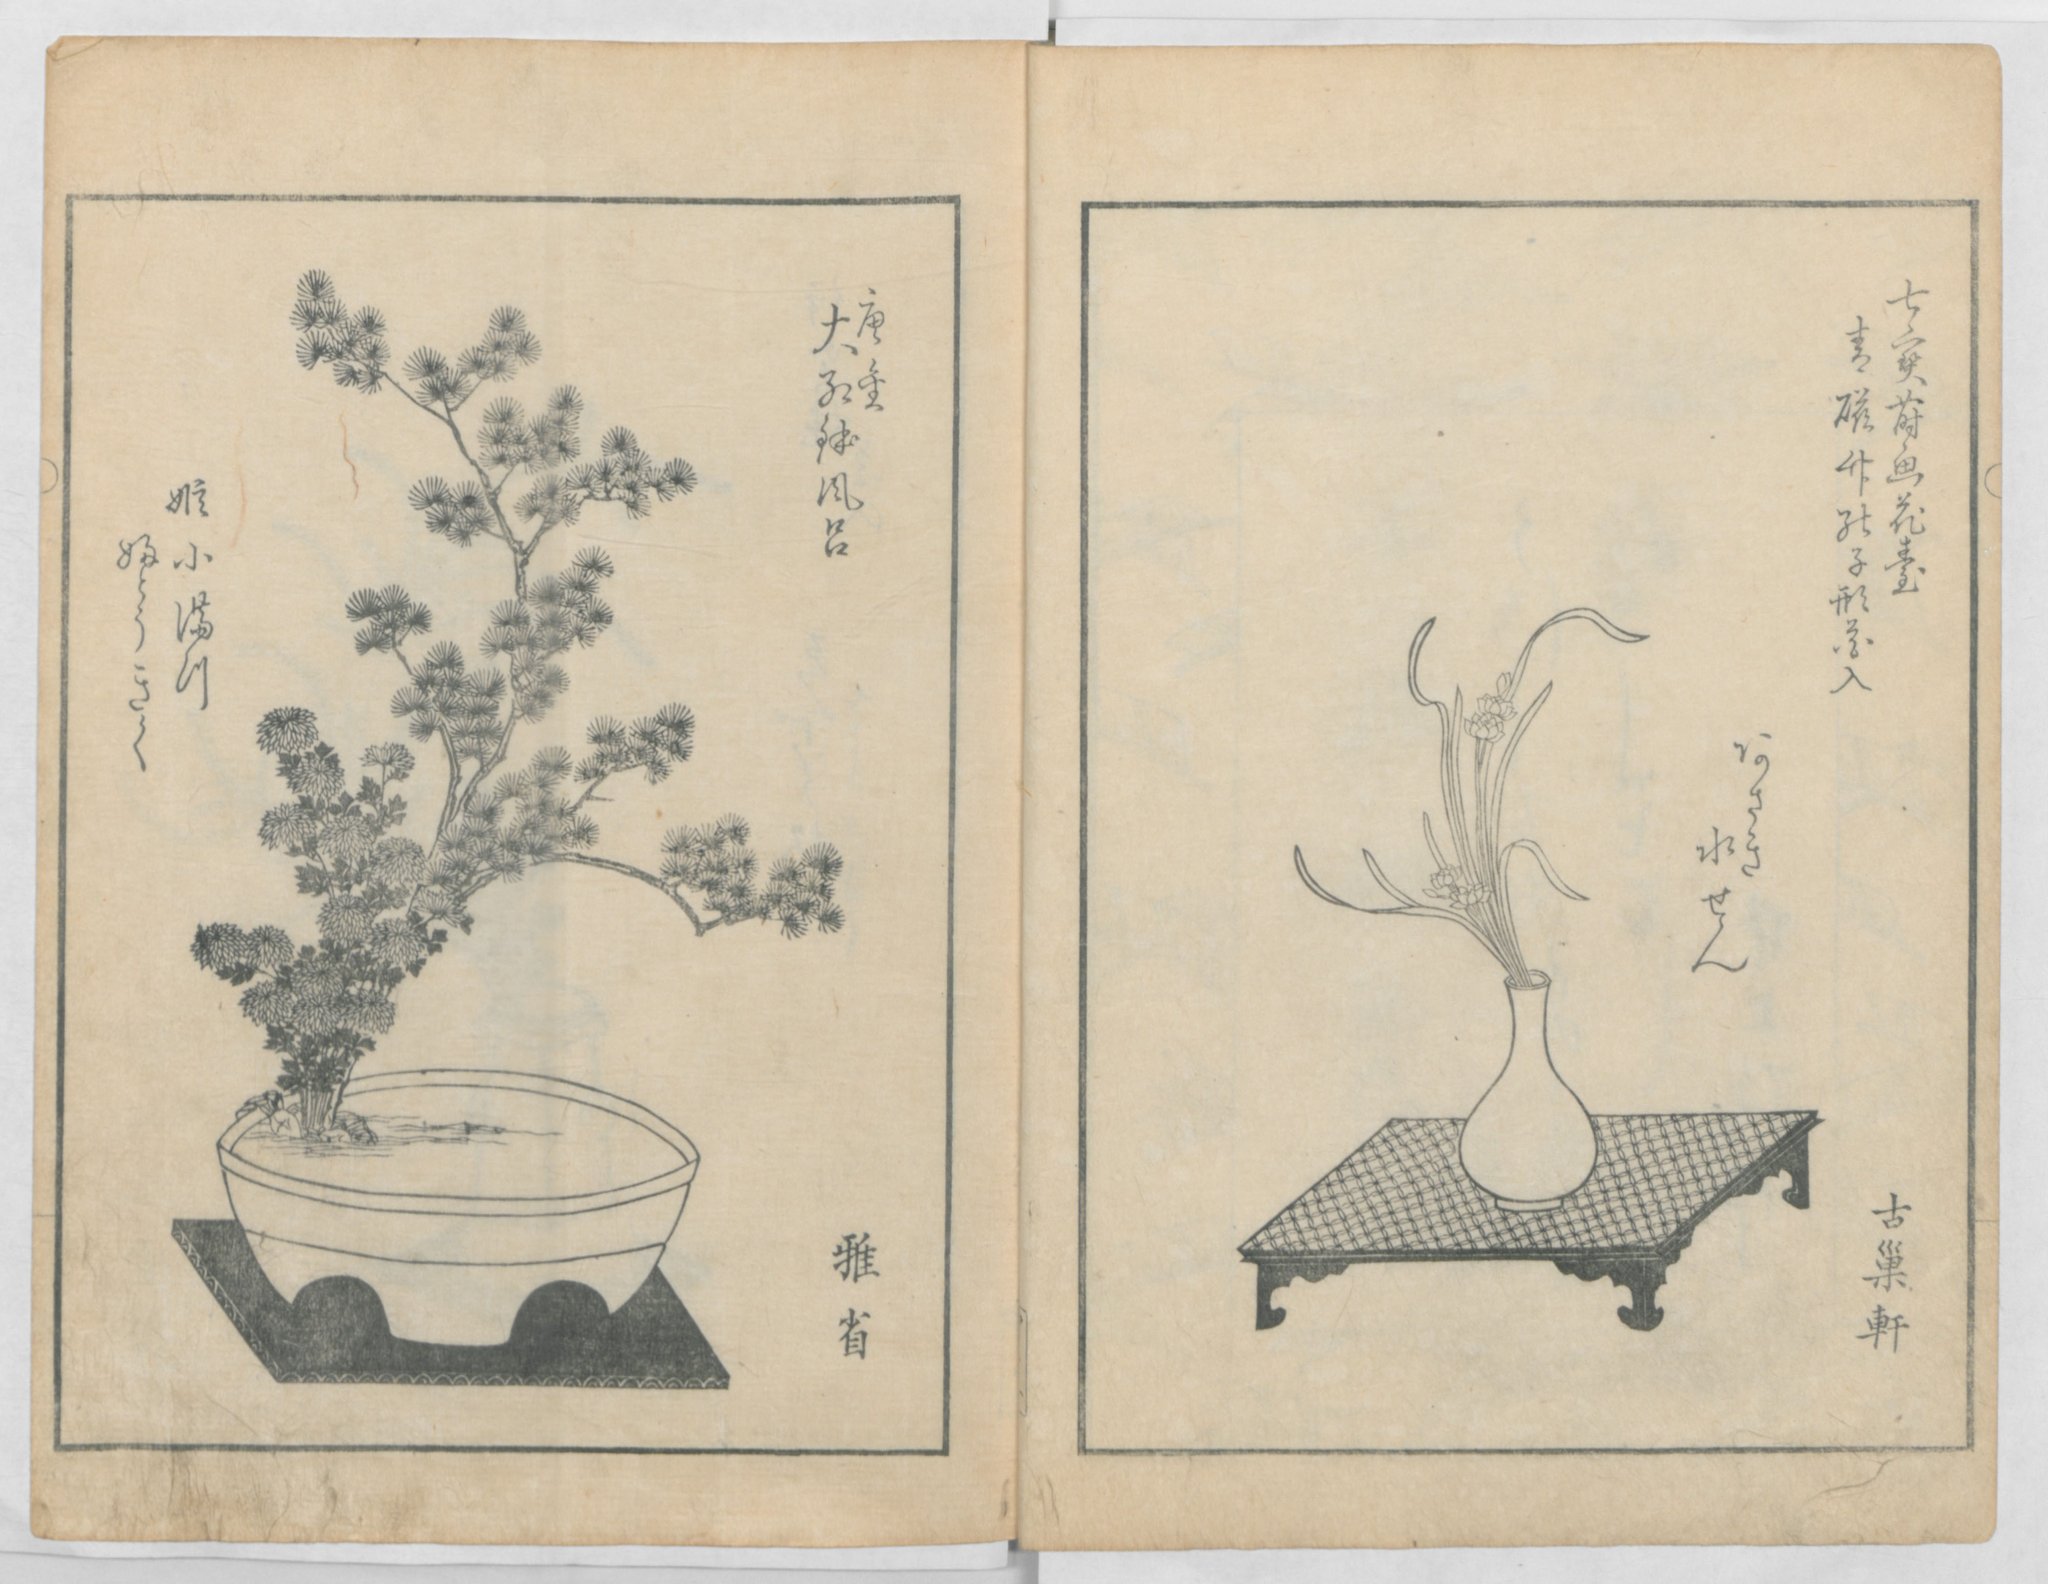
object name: illustrated book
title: A Book on Flower Arrangement: Hare's-Foot Fern (Shinobugusa) 師廼部供作 (vol. 2); 思乃父魚砂 (vol. 3)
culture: japanese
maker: yoshida tōgetsu 吉田桃月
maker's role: artist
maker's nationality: japanese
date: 1822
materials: ink, paper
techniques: woodblock print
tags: flowers,plants